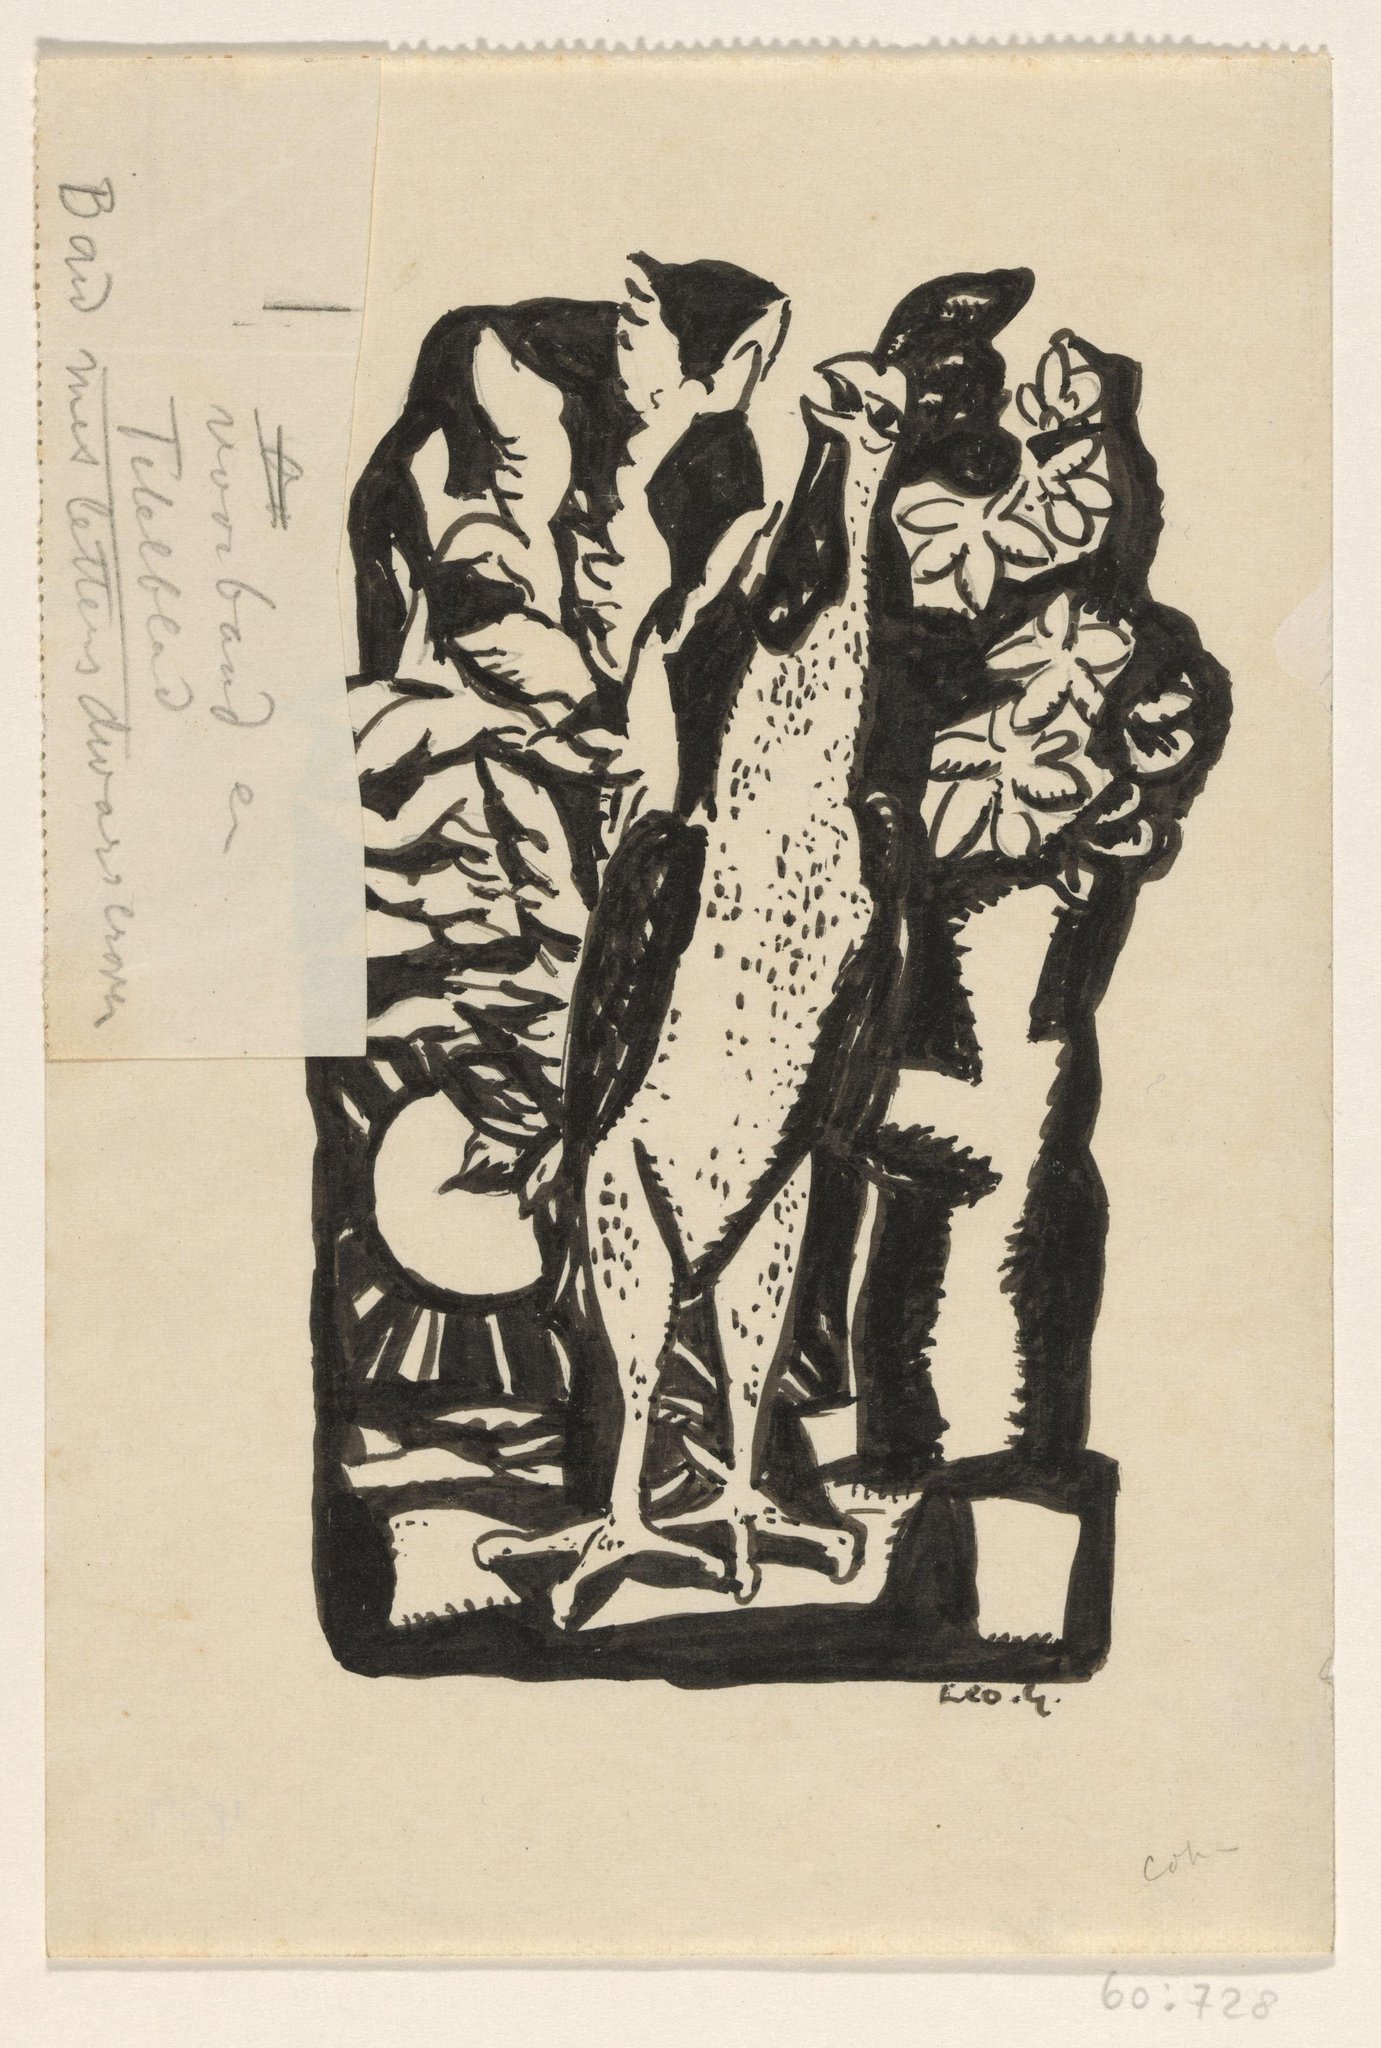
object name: drawing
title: Kraaiende haan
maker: leo gestel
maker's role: draughtsman, print maker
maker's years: 1881-1941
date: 1934-1936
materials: ink, paper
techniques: brush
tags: (cohen, van anarchist tot monarchist) specific works of literature (with author, title), fowl (cock, hen, chicken, etc.) (+ male animal)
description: Ontwerp voor een boekband voor: Cohen, Alexander. Van anarchist tot monarchist. Amsterdam: De Steenuil, 1936.